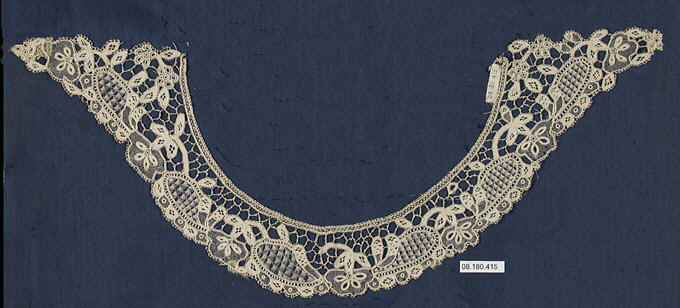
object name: collar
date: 1867-1900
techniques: lace